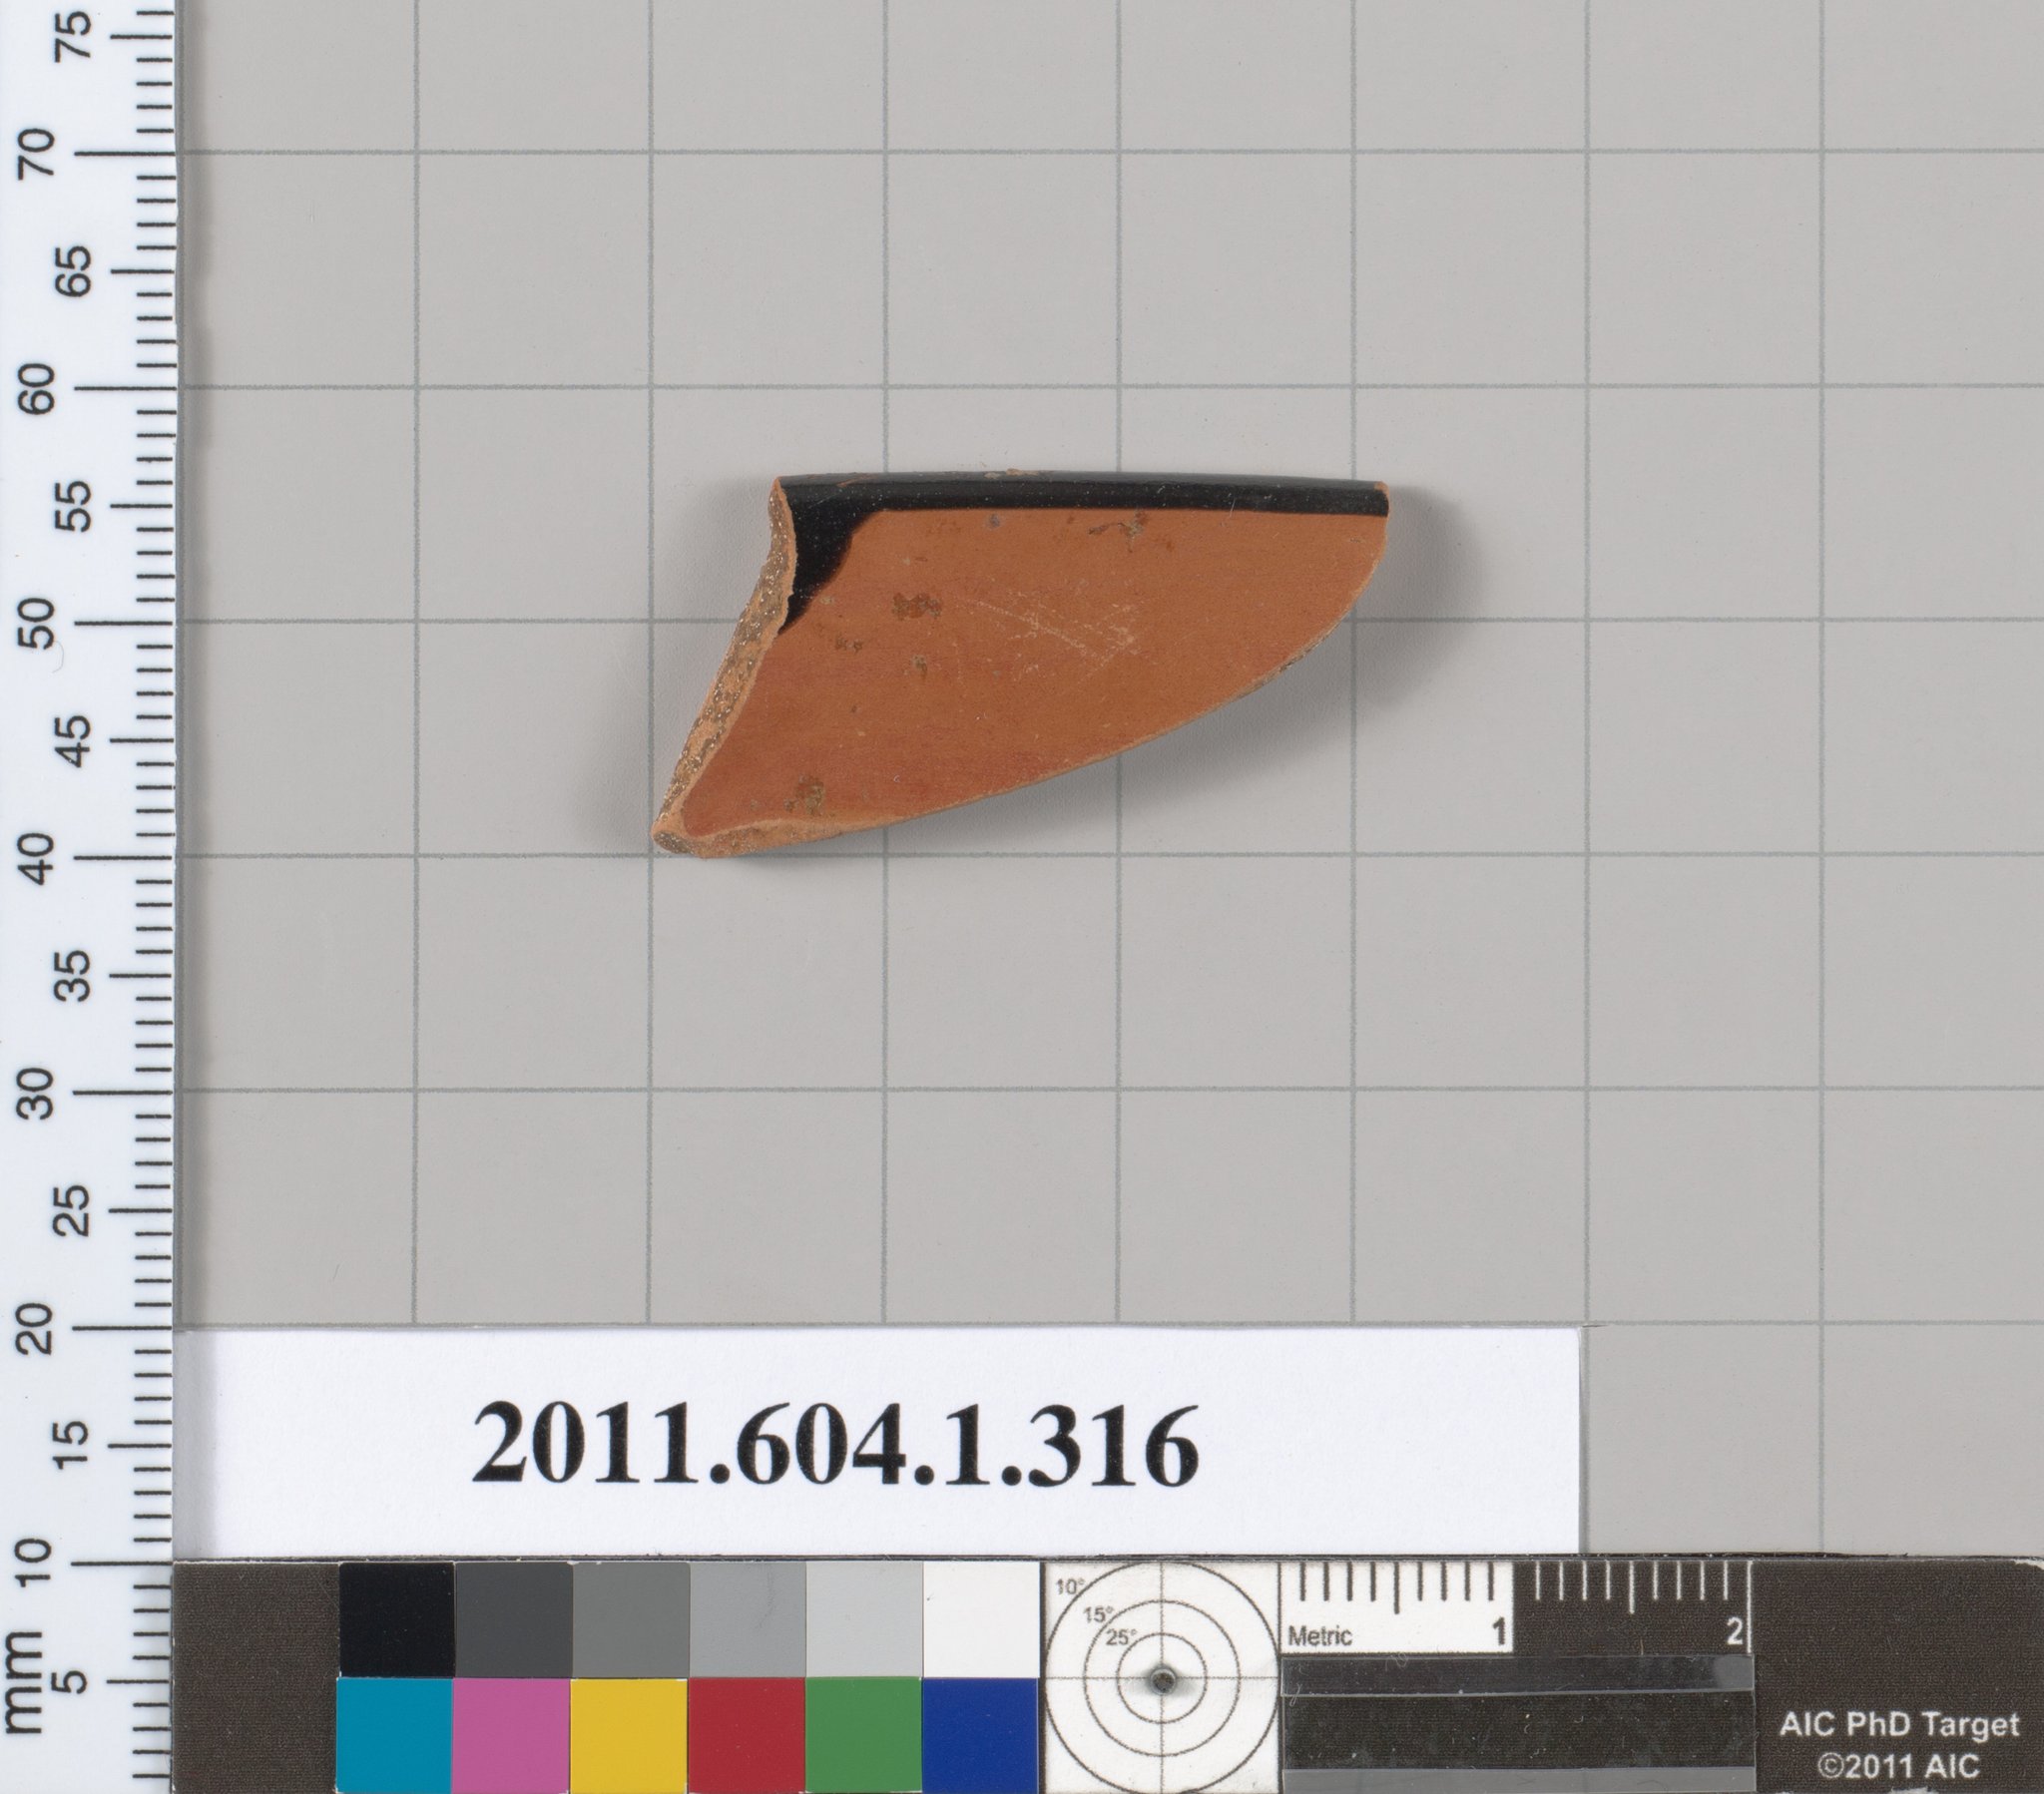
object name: kylix fragment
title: Terracotta rim fragment of a kylix (drinking cup)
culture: greek, attic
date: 475-451 BCE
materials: terracotta